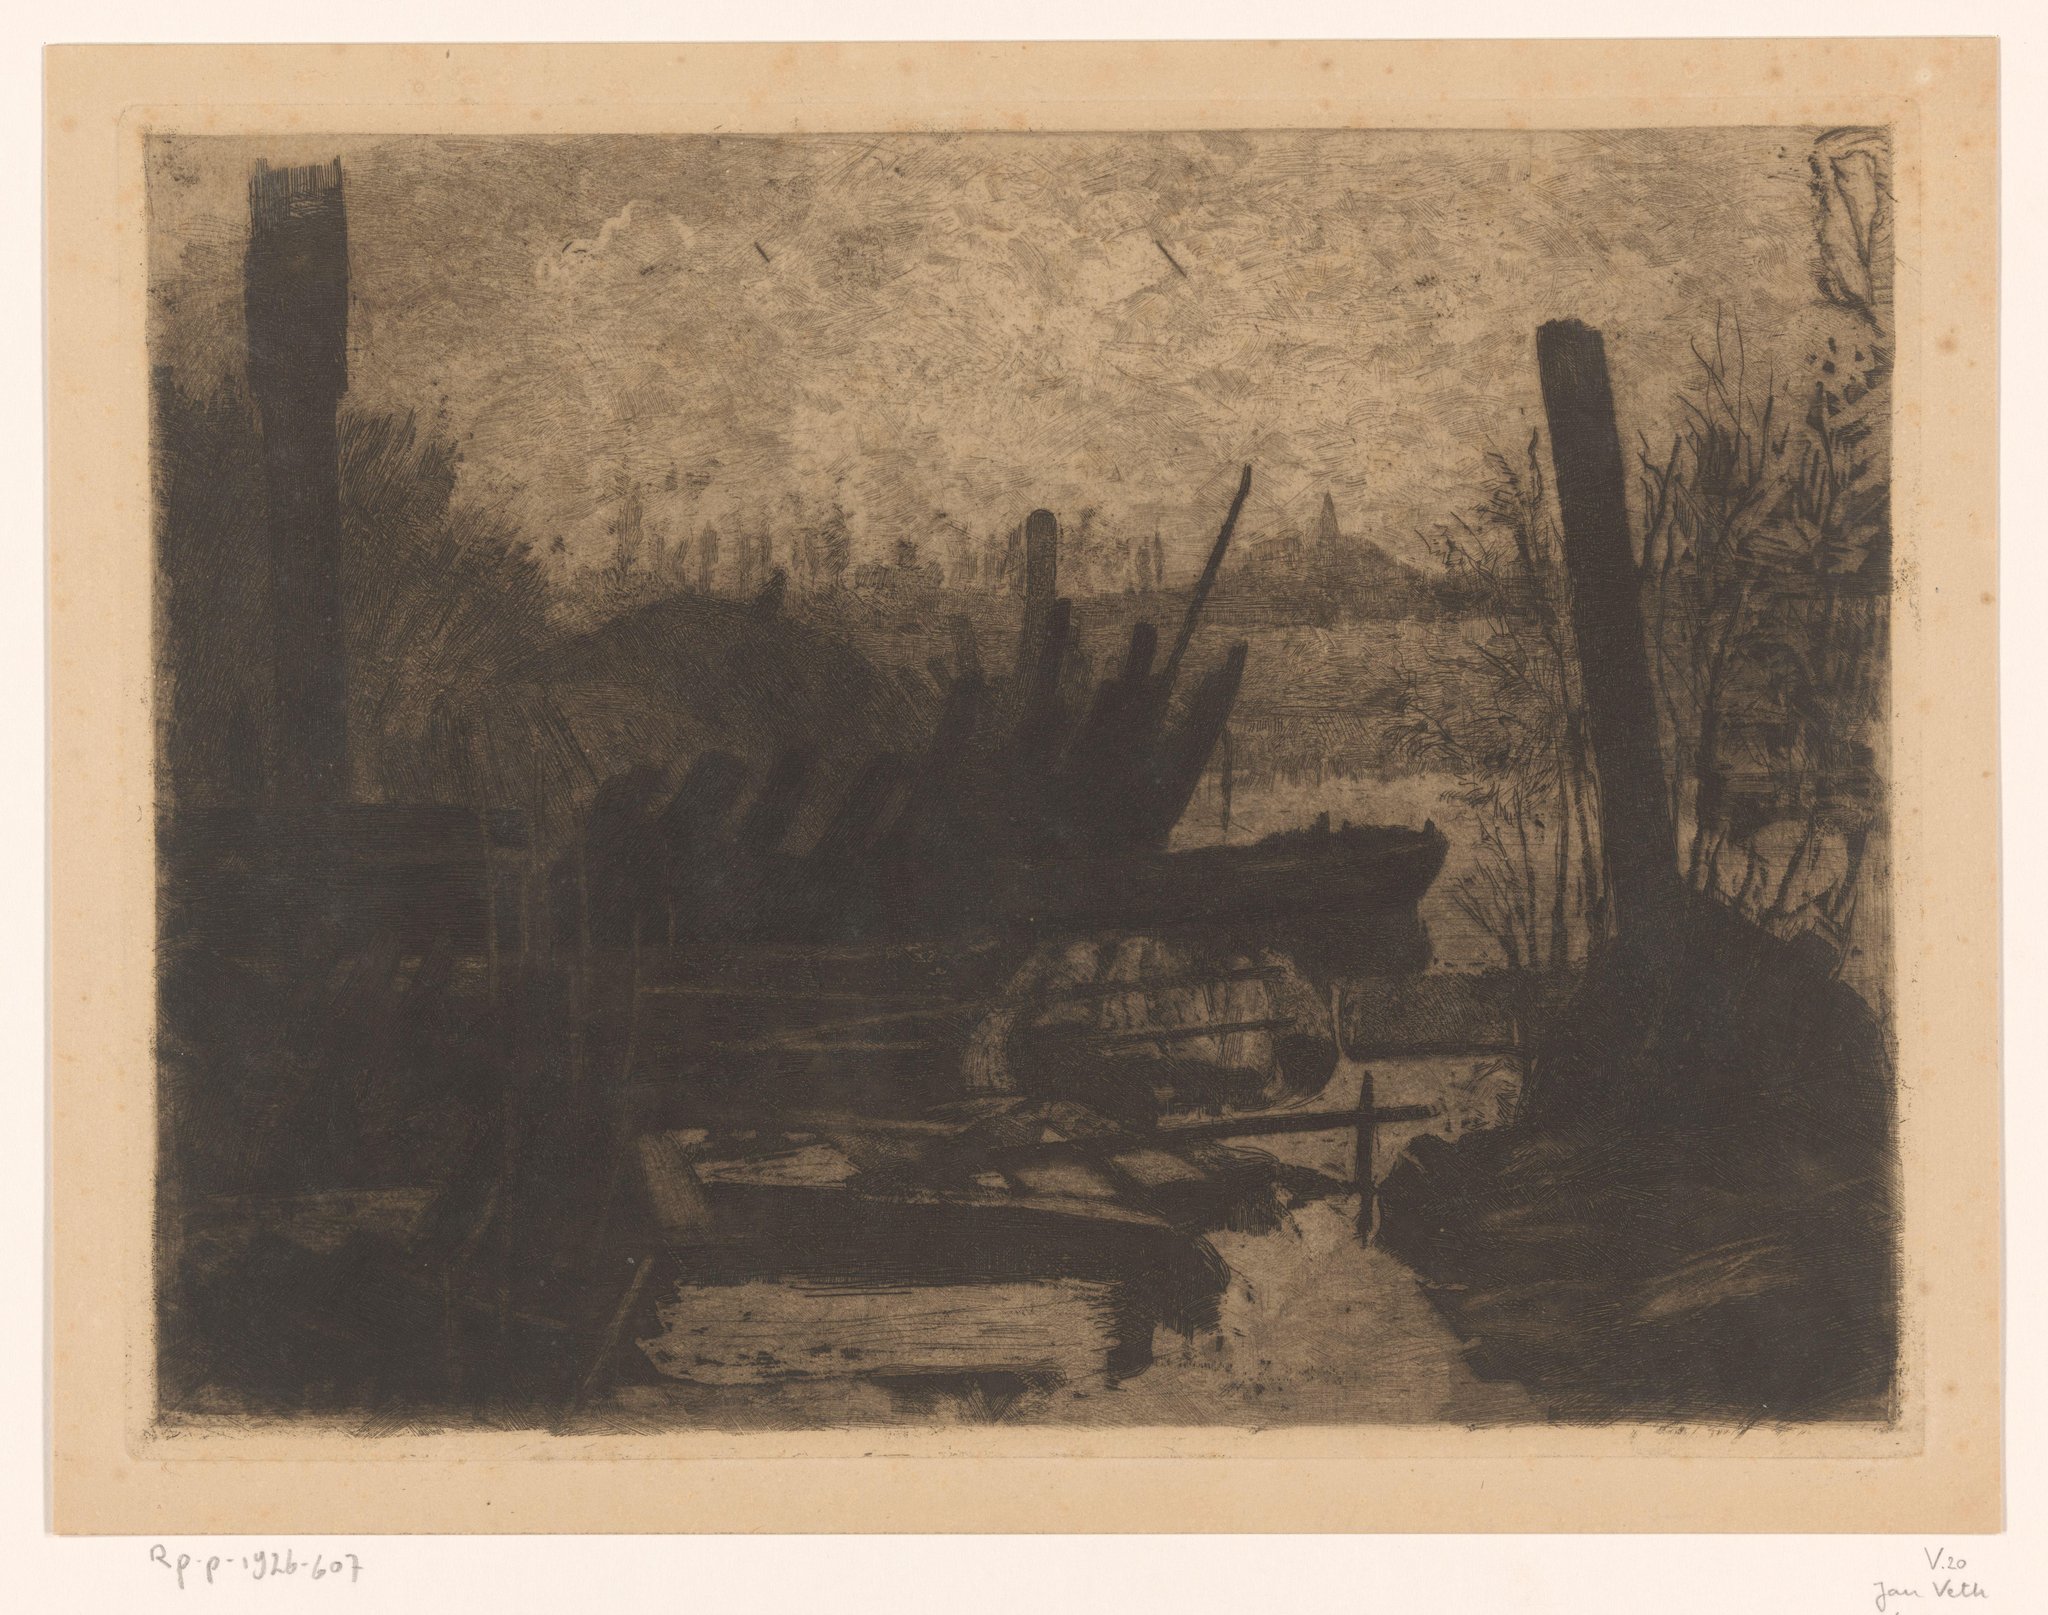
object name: print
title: Wrakken in een polderlandschap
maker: jan veth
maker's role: designer, draughtsman, painter, print maker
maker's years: 1864-1925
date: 1886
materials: paper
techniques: etching, intaglio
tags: wreck ashore, polder, reclaimed land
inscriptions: collector's mark: Lugt 2228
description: Prent verscheen in 1888 als onderdeel van de jaarlijkse uitgave van de 'Portefeuille der Nederlandsche Etsclub'.